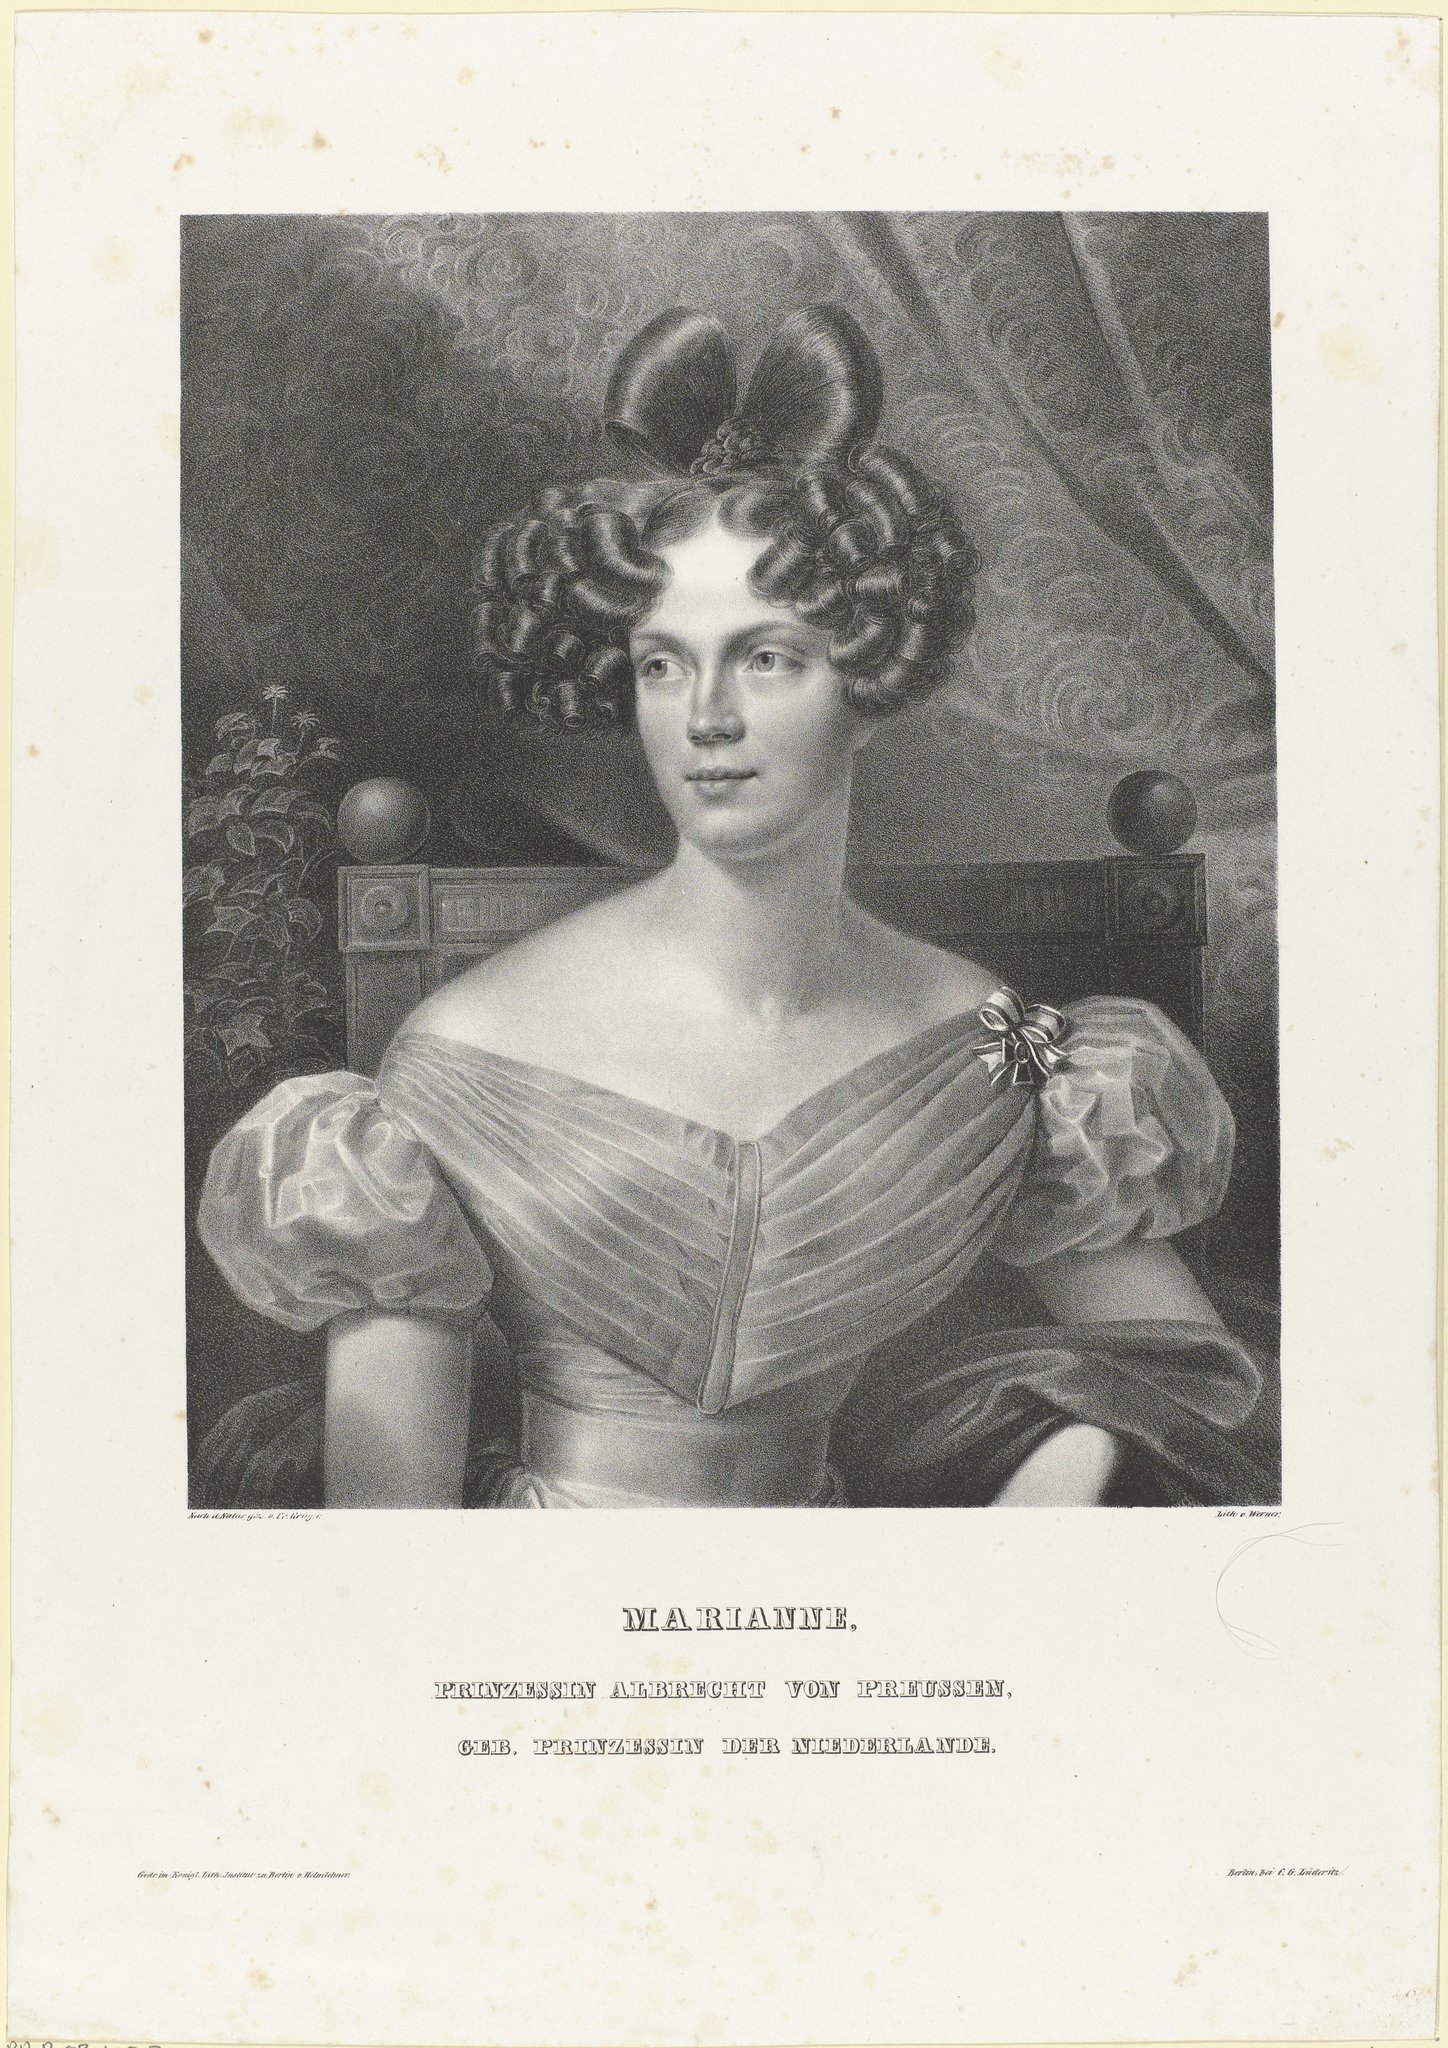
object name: print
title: Portret van Marianne, prinses der Nederlanden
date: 1831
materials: paper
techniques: lithograph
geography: berlin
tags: berlin, voorburg, marianne (prinses der nederlanden)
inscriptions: collector's mark: Lugt 963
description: De hier vermelde titel verwijst naar de hoogst verkregen titel van de geportretteerde, niet per se naar de titel die de geportretteerde op deze voorstelling draagt.